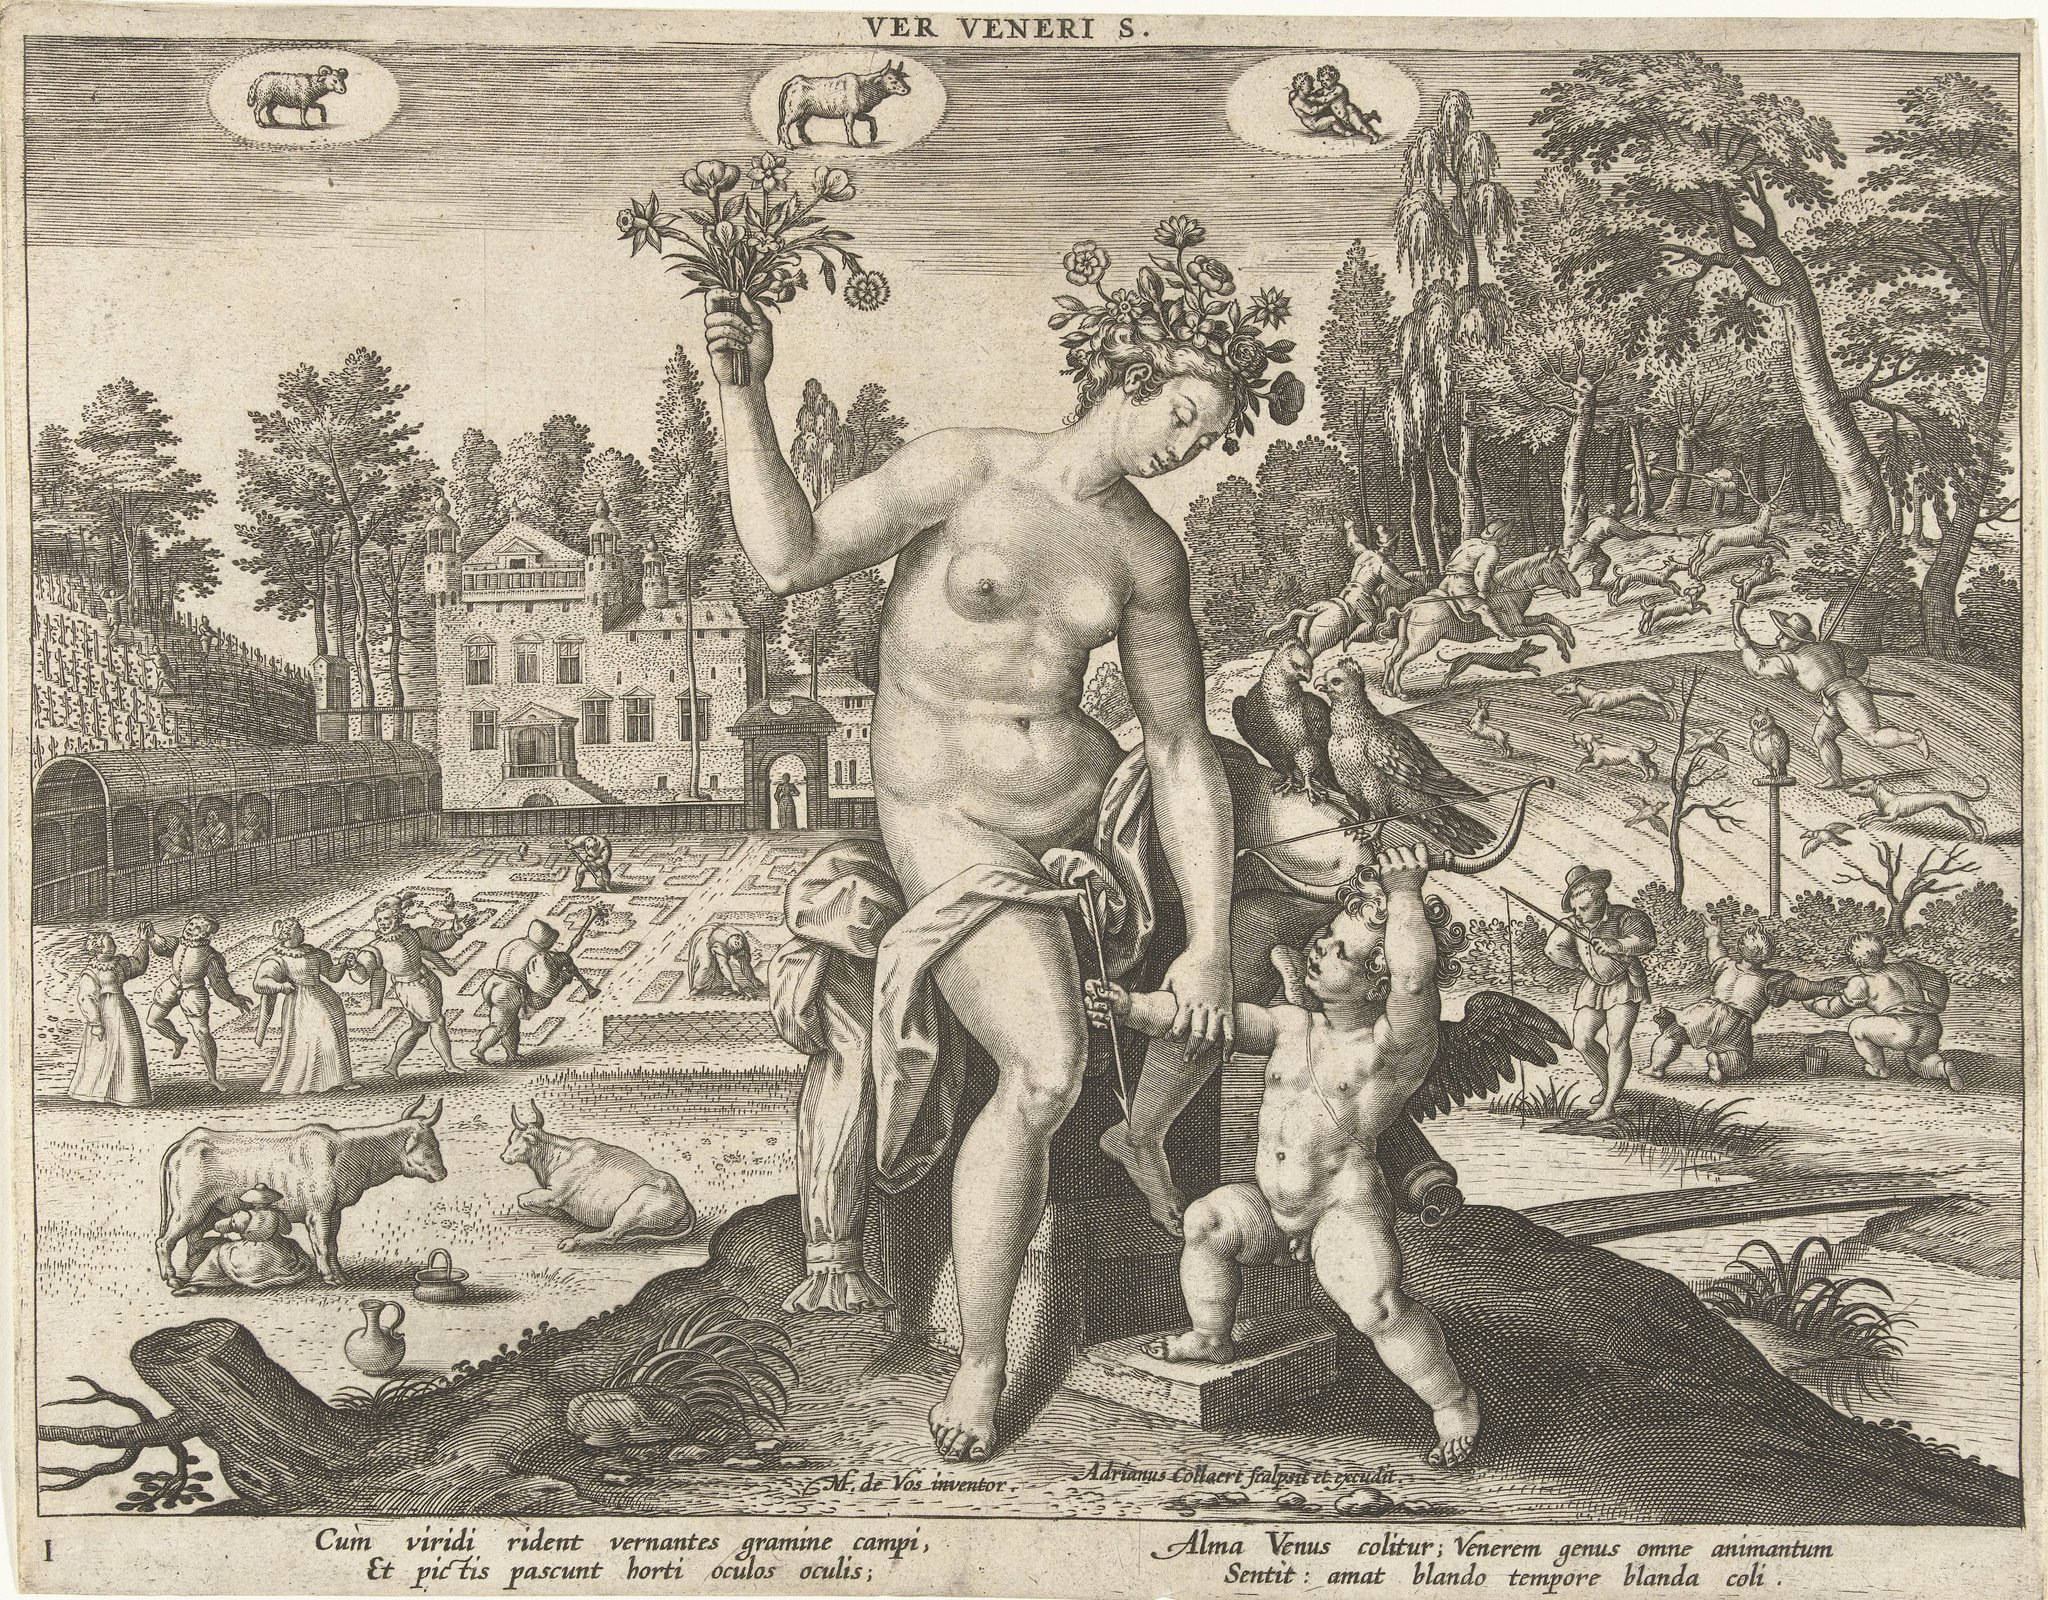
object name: print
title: Lente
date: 1570-1618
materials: paper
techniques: engraving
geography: antwerp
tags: spring landscape; landscape symbolizing spring (the four seasons of the year) (+ with venus), spring landscape; landscape symbolizing spring (the four seasons of the year) (+ with scenes showing human occupations ~ seasons and months), spring landscape; landscape symbolizing spring (the four seasons of the year) (+ with zodiacal signs of the spring season)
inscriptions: collector's mark: Lugt 2228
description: Op de voorgrond Venus en Cupido. Venus houdt een bloementuil in haar handen. Op de achtergrond voorjaarstaferelen: een melkende boerin, dansende paartjes, tuinieren, vissen, vogelvangst en de jacht. Boven in de lucht de drie astrologische tekens van het voorjaar: Ram, Stier en Tweeling. De prent heeft een Latijns onderschrift en is deel van een vierdelige serie over de vier seizoenen.